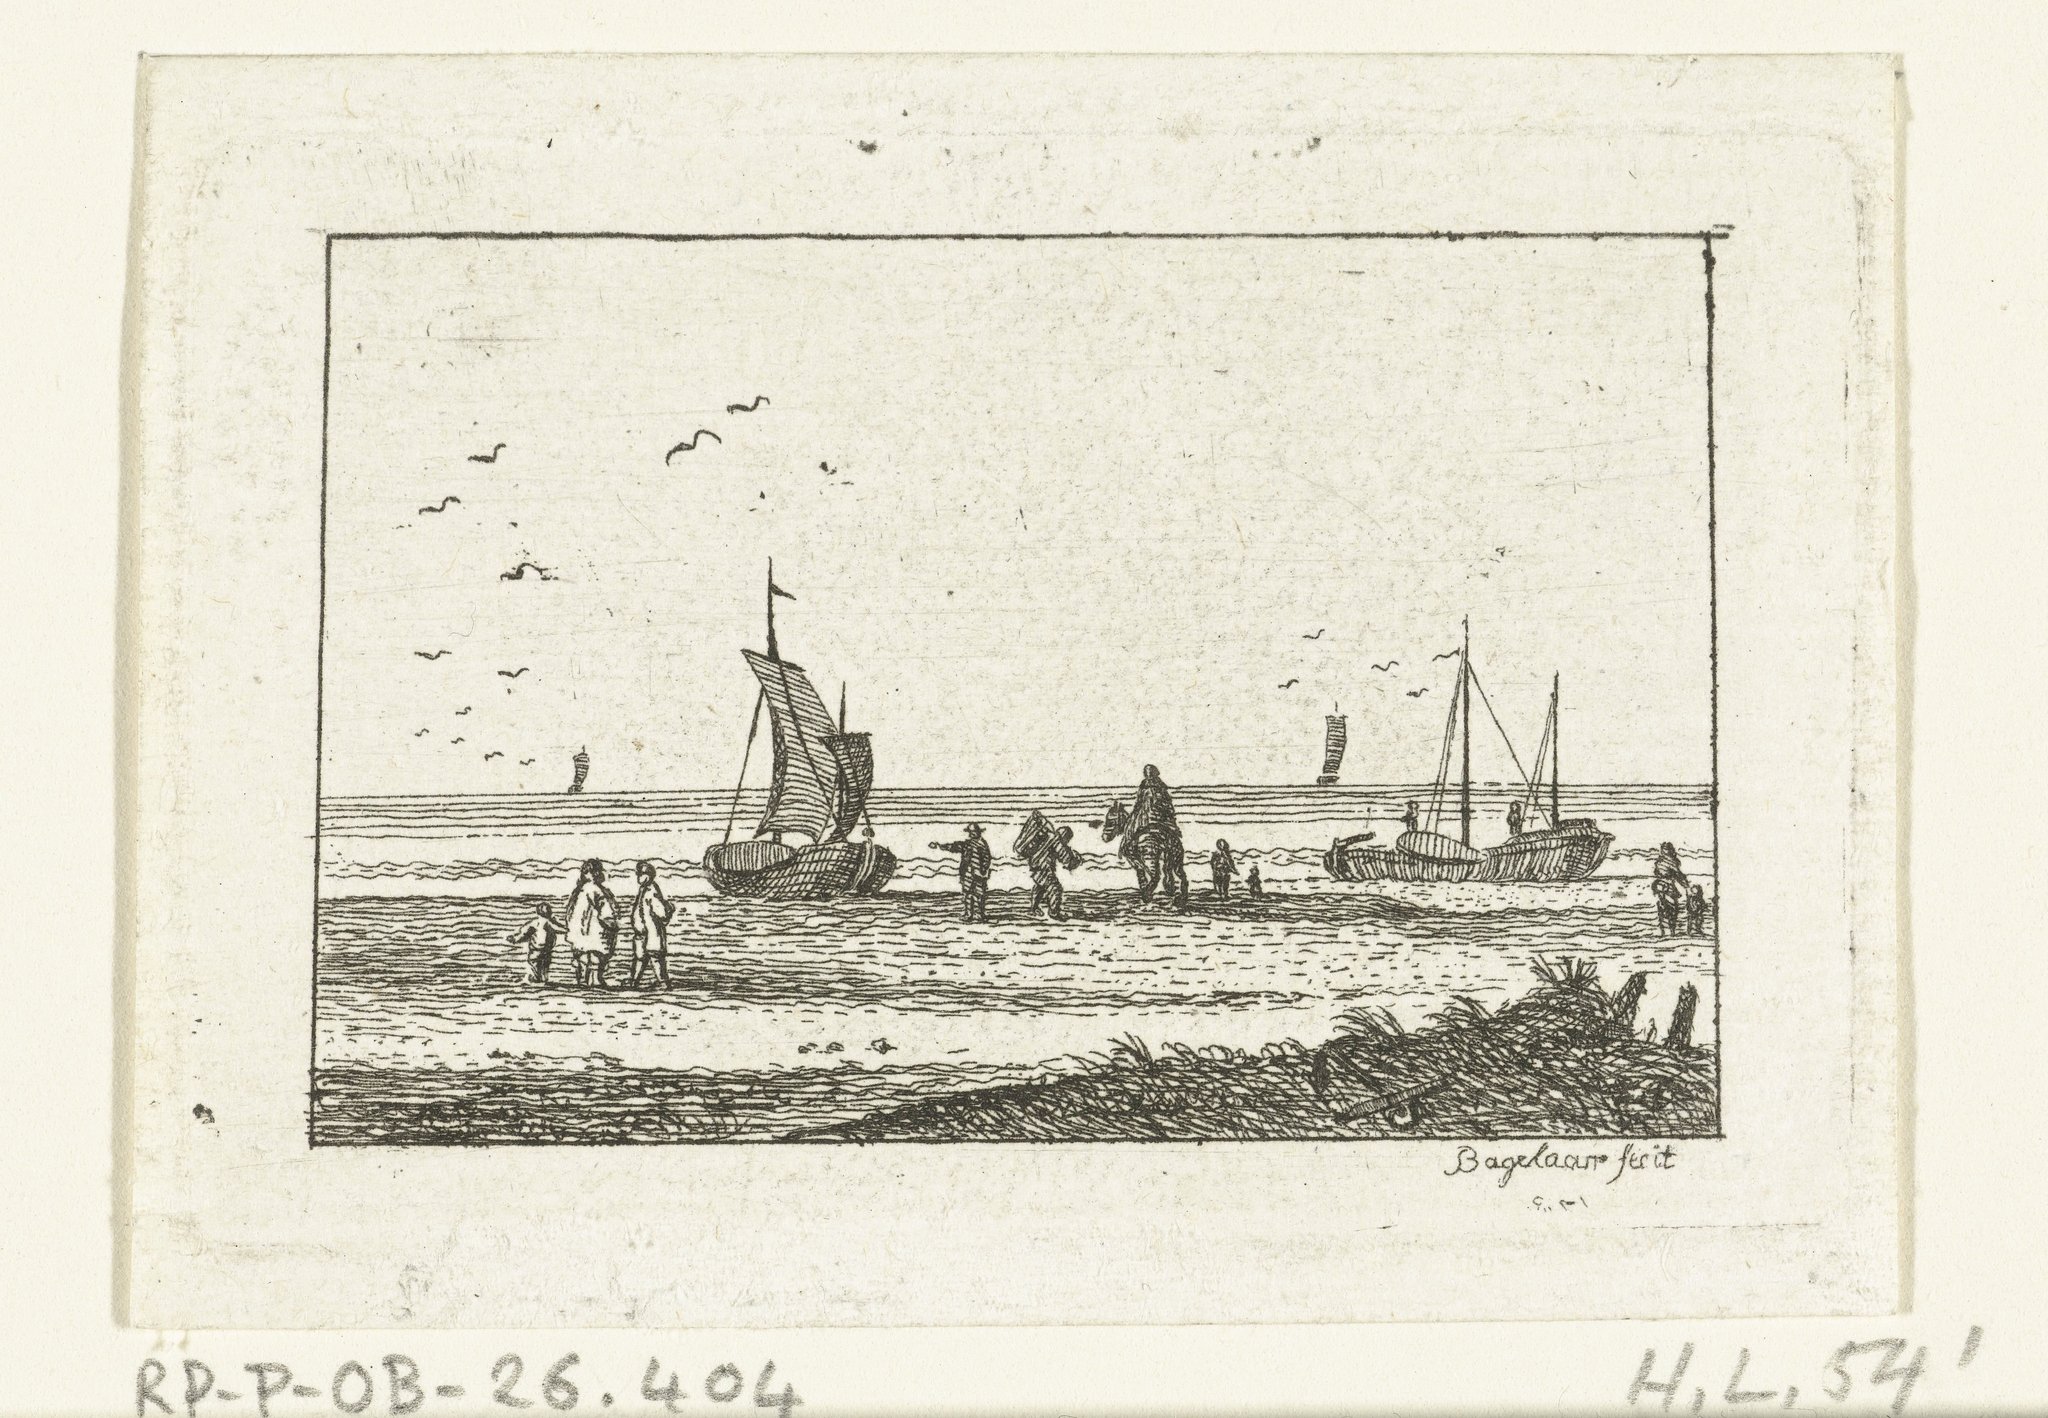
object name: print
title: Gezicht op het strand met twee boten en een ruiter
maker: ernst willem jan bagelaar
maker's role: draughtsman, print maker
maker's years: 1775-1837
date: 1798-1837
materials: paper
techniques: etching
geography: netherlands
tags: sea (seascape)